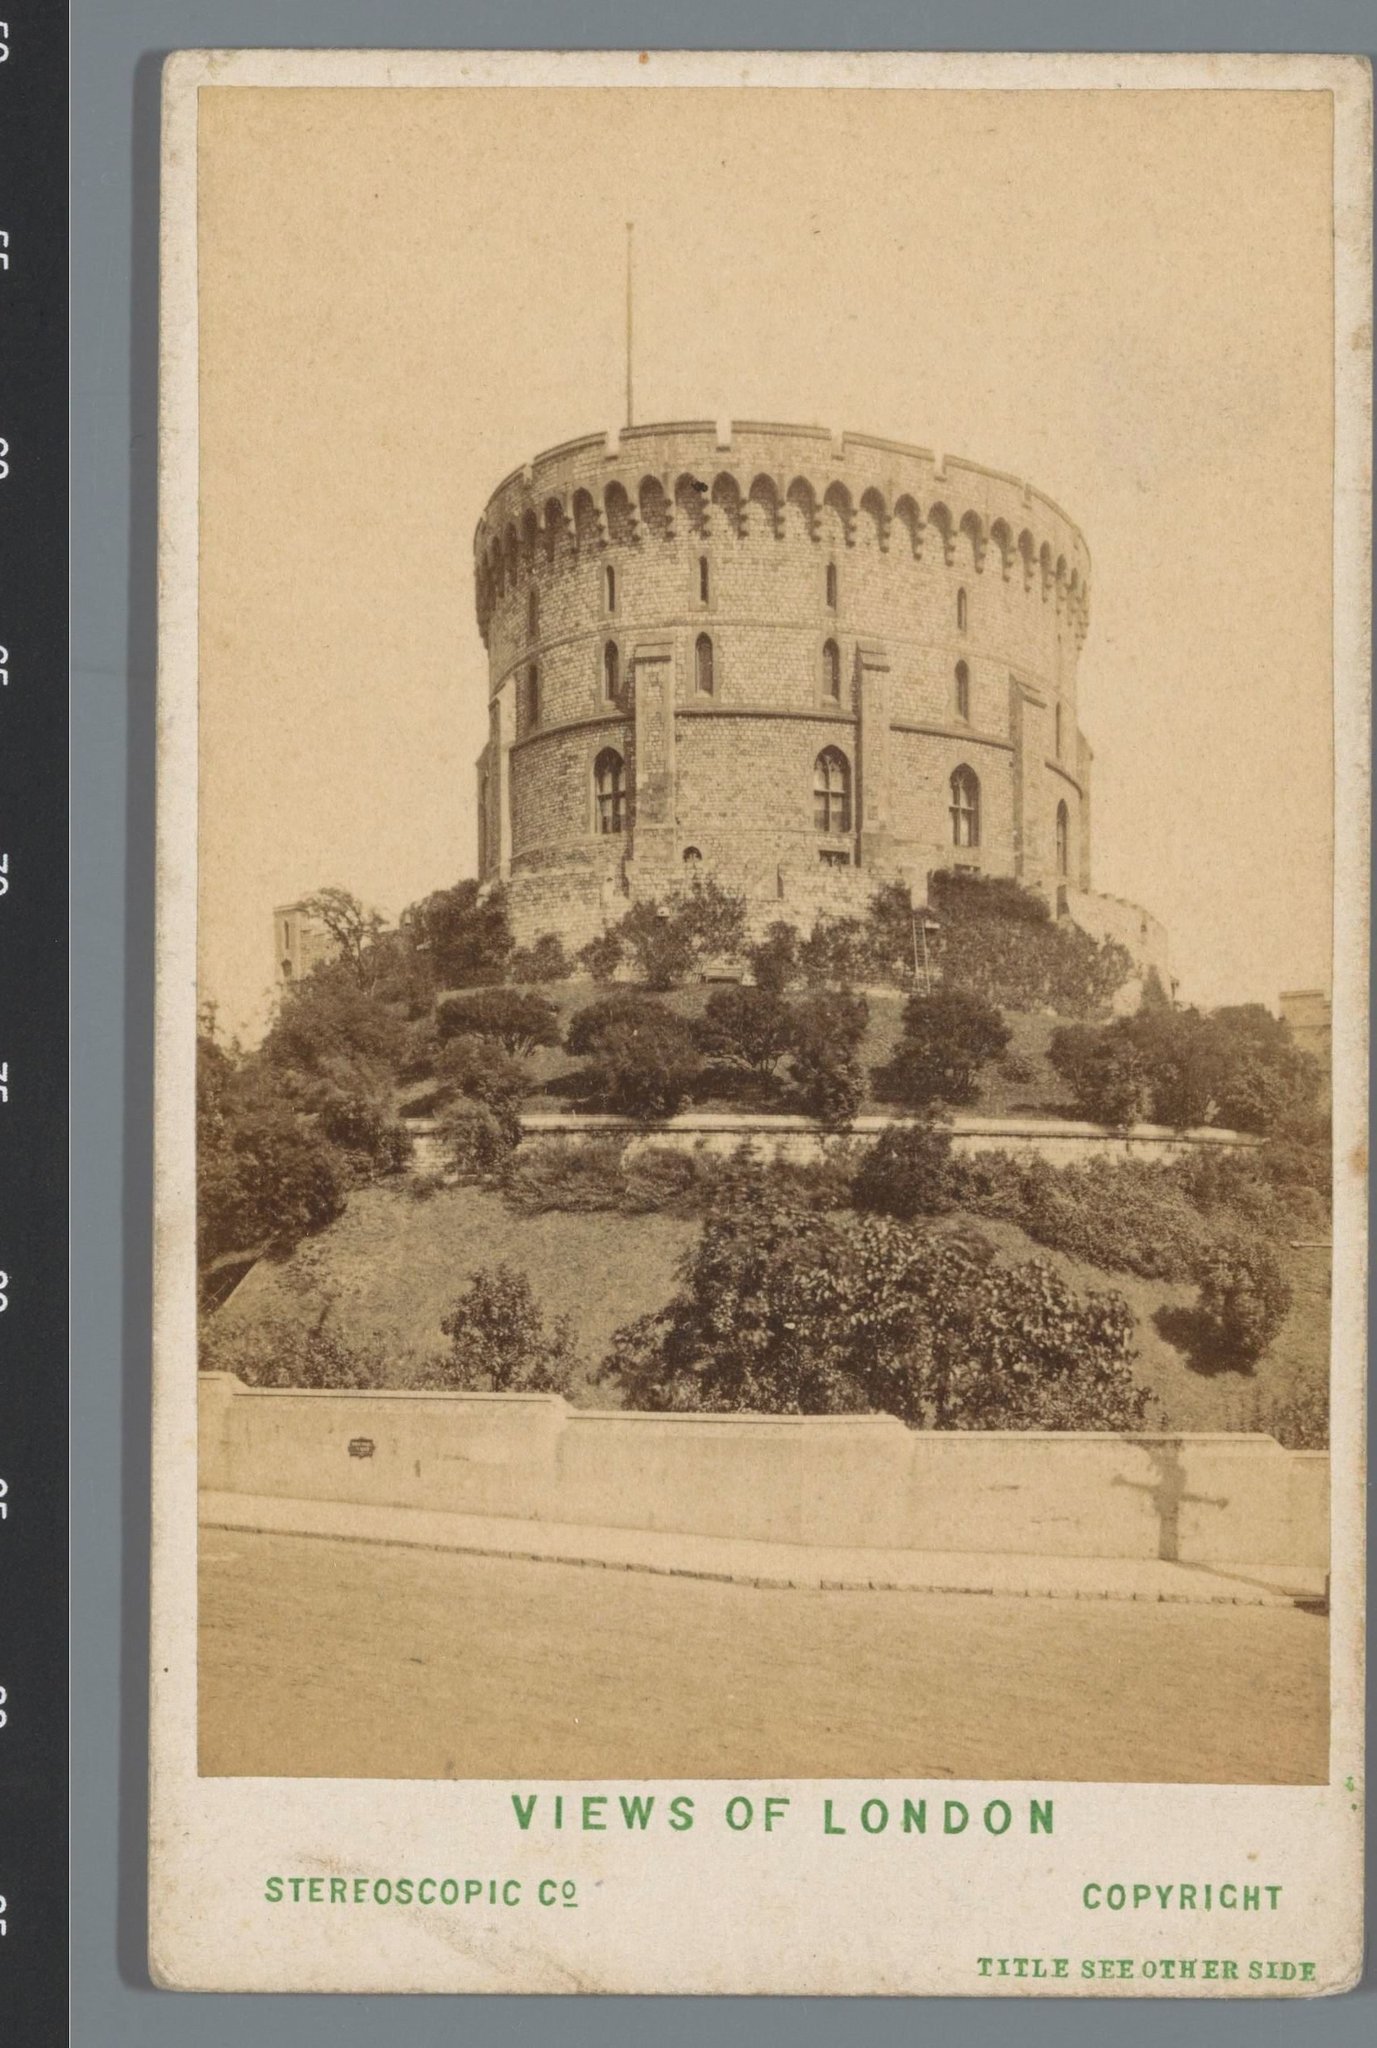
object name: carte de visite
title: Windsor Castle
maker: Anonymous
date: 1862-1873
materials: cardboard, paper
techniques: albumen print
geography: windsor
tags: castle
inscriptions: inscription: ‘PHOTOGRAPHERS TO H.R.H. THE PRINCE OF WALES,/ AND/ TO H.R.H. THE DUKE OF EDINBURGH./ BERLIN/ LONDON/ DUBLIN/ NEW YORK/ SOLE PHOTOGRAPHERS TO THE INTERNATIONAL EXHIBITION 1862/ THE LONDON/ STEREOSCOPIC & PHOTOGRAPHIC/ COMPANY/ 54, CHEAPSIDE,/ AND/ 110 & 108, REGENT STREET./ THIS NEGATIVE IS PRESERVED FOR FURTHER COPIES/ ENLARGEMENTS CAN AT ANY TIME BE PRODUCED/ WITHOUT ANOTHER SITTING.’